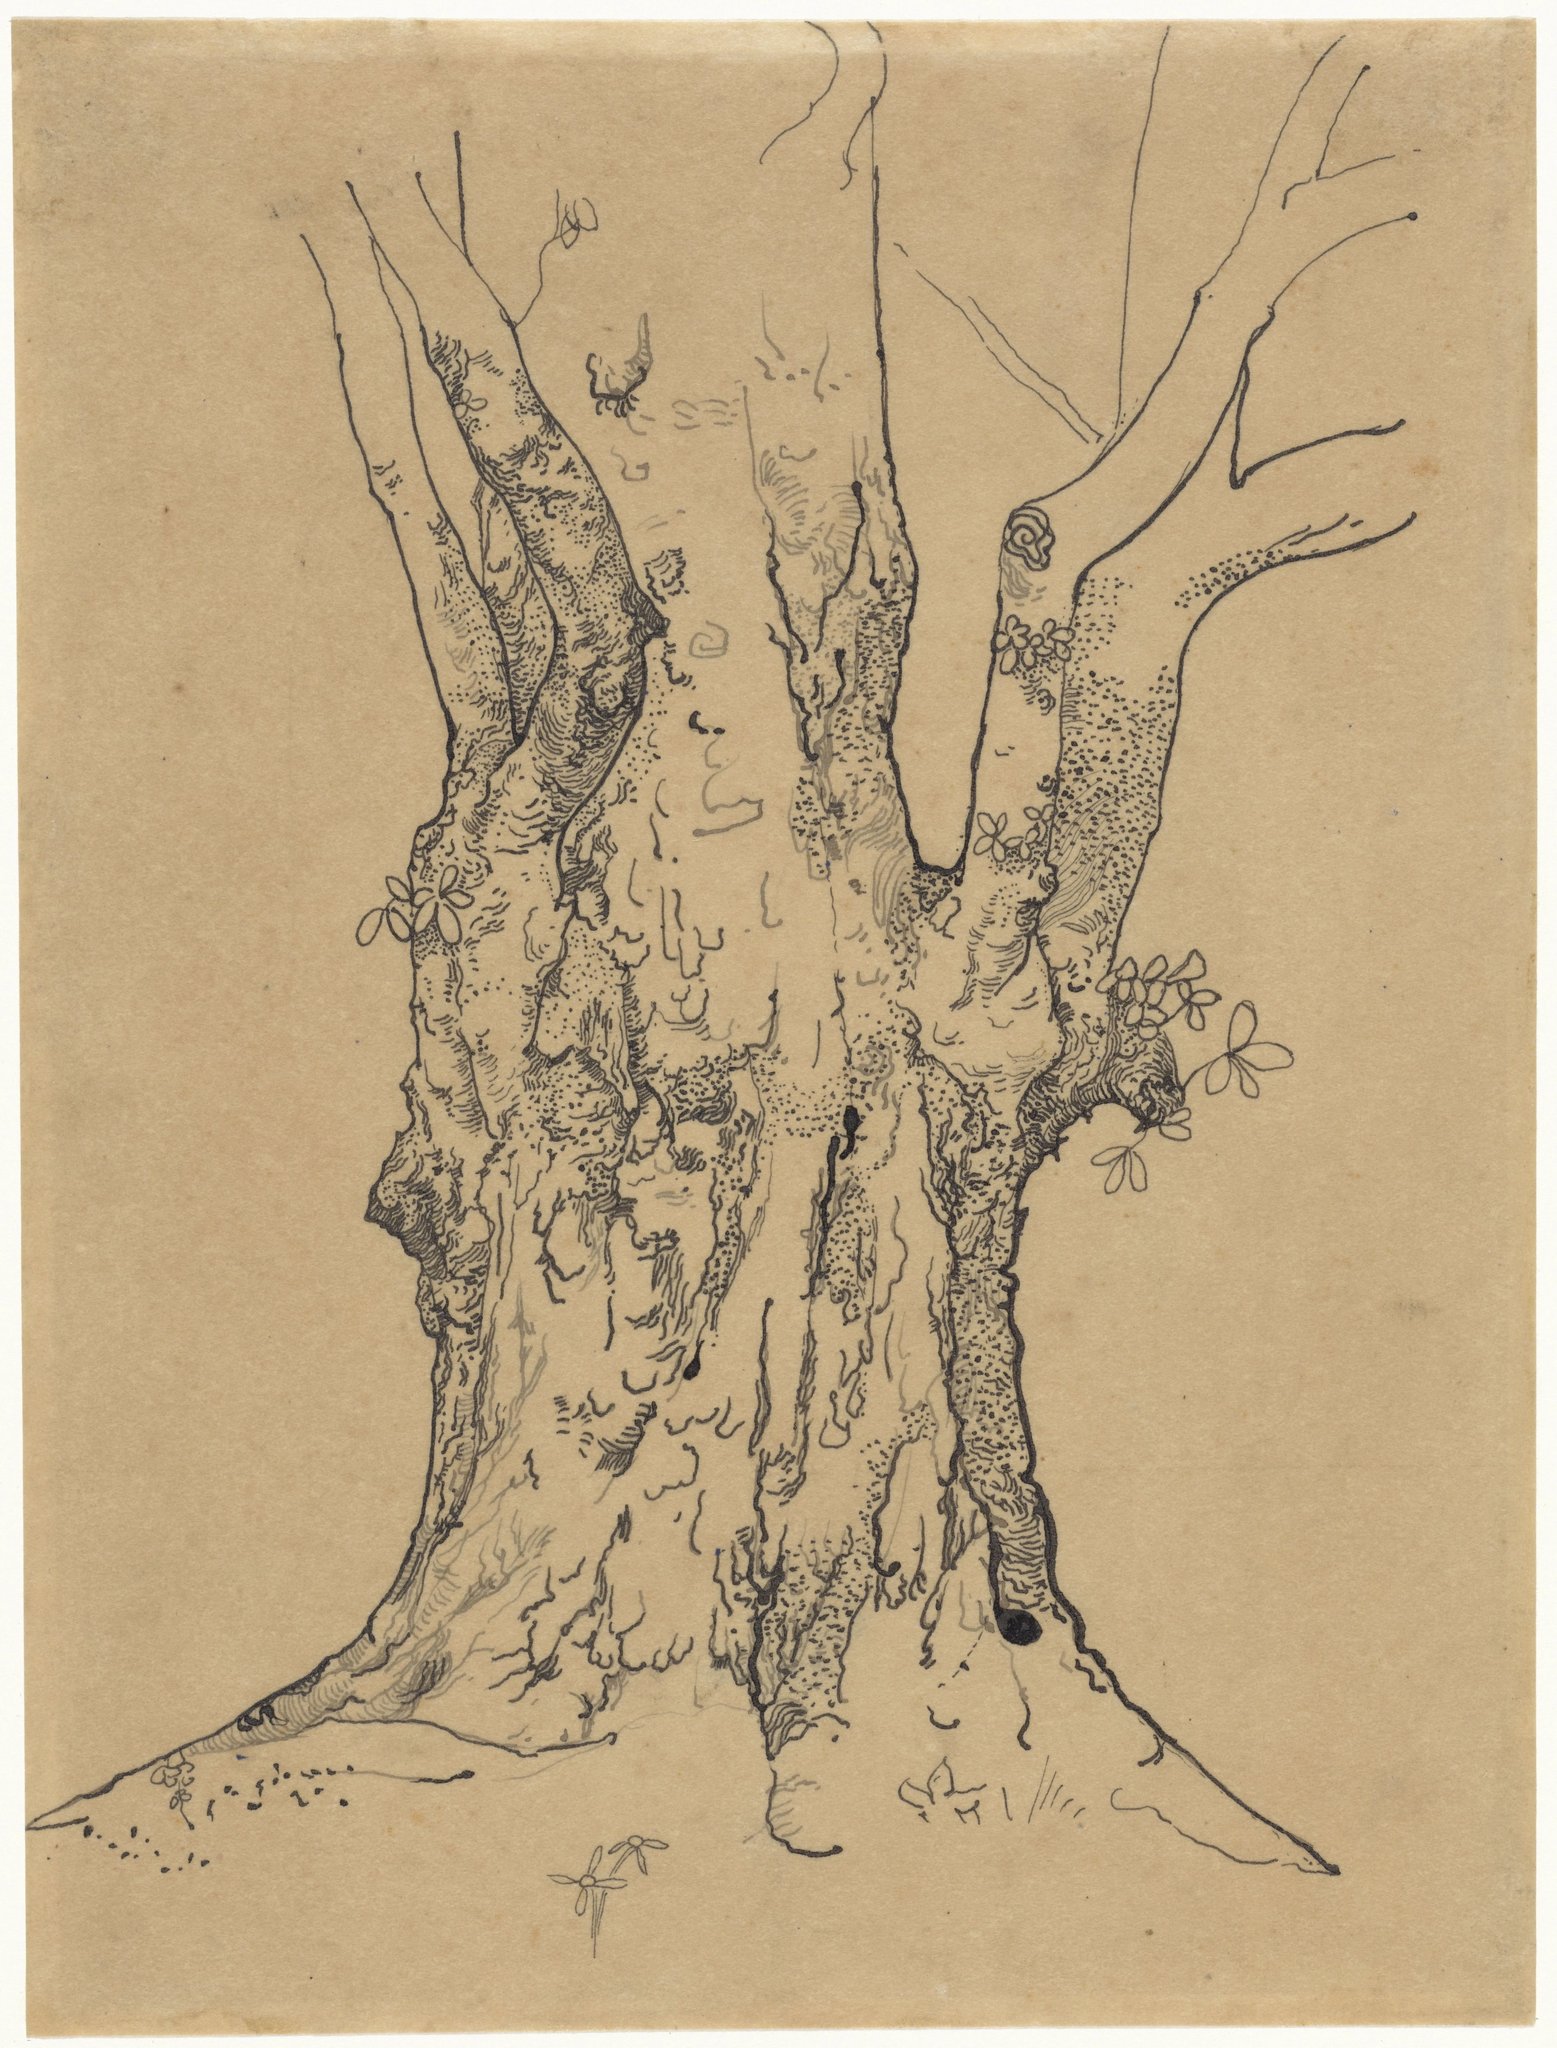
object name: drawing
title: Dikke boomstam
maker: richard nicolaüs roland holst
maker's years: 1868-1938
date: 1878-1938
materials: ink, paper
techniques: pen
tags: trees